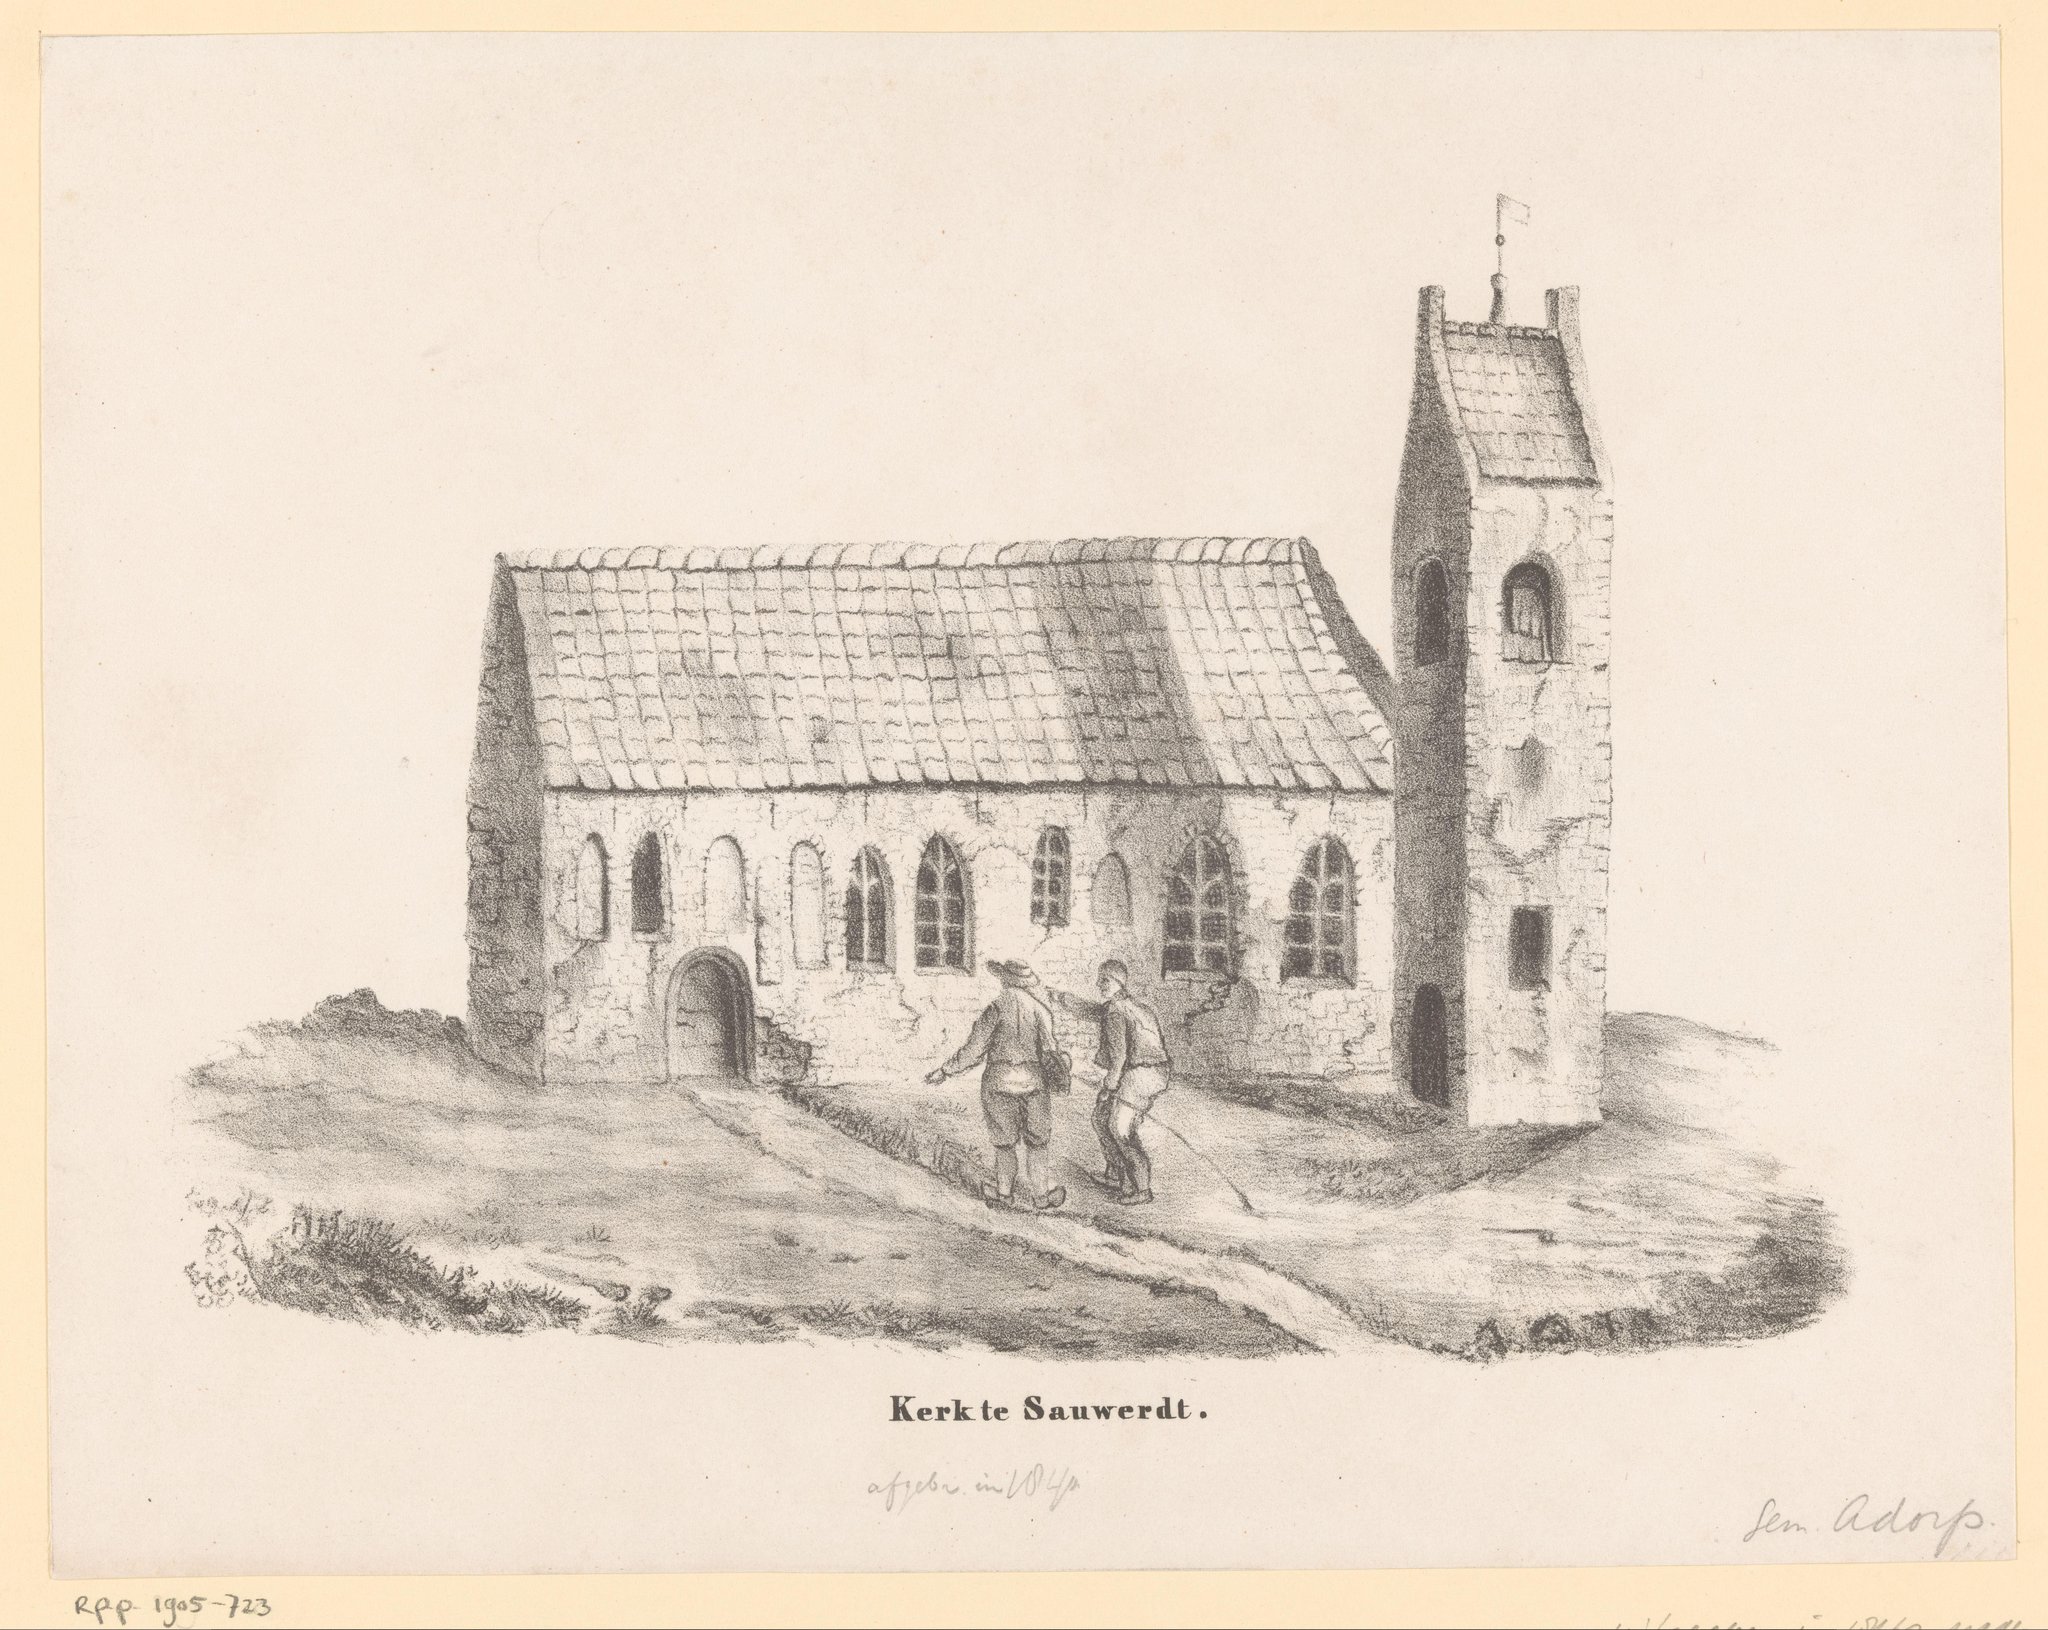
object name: print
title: Kerk te Sauwerd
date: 1830-1850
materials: paper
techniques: lithograph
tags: church (exterior)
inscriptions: collector's mark: Lugt 2228